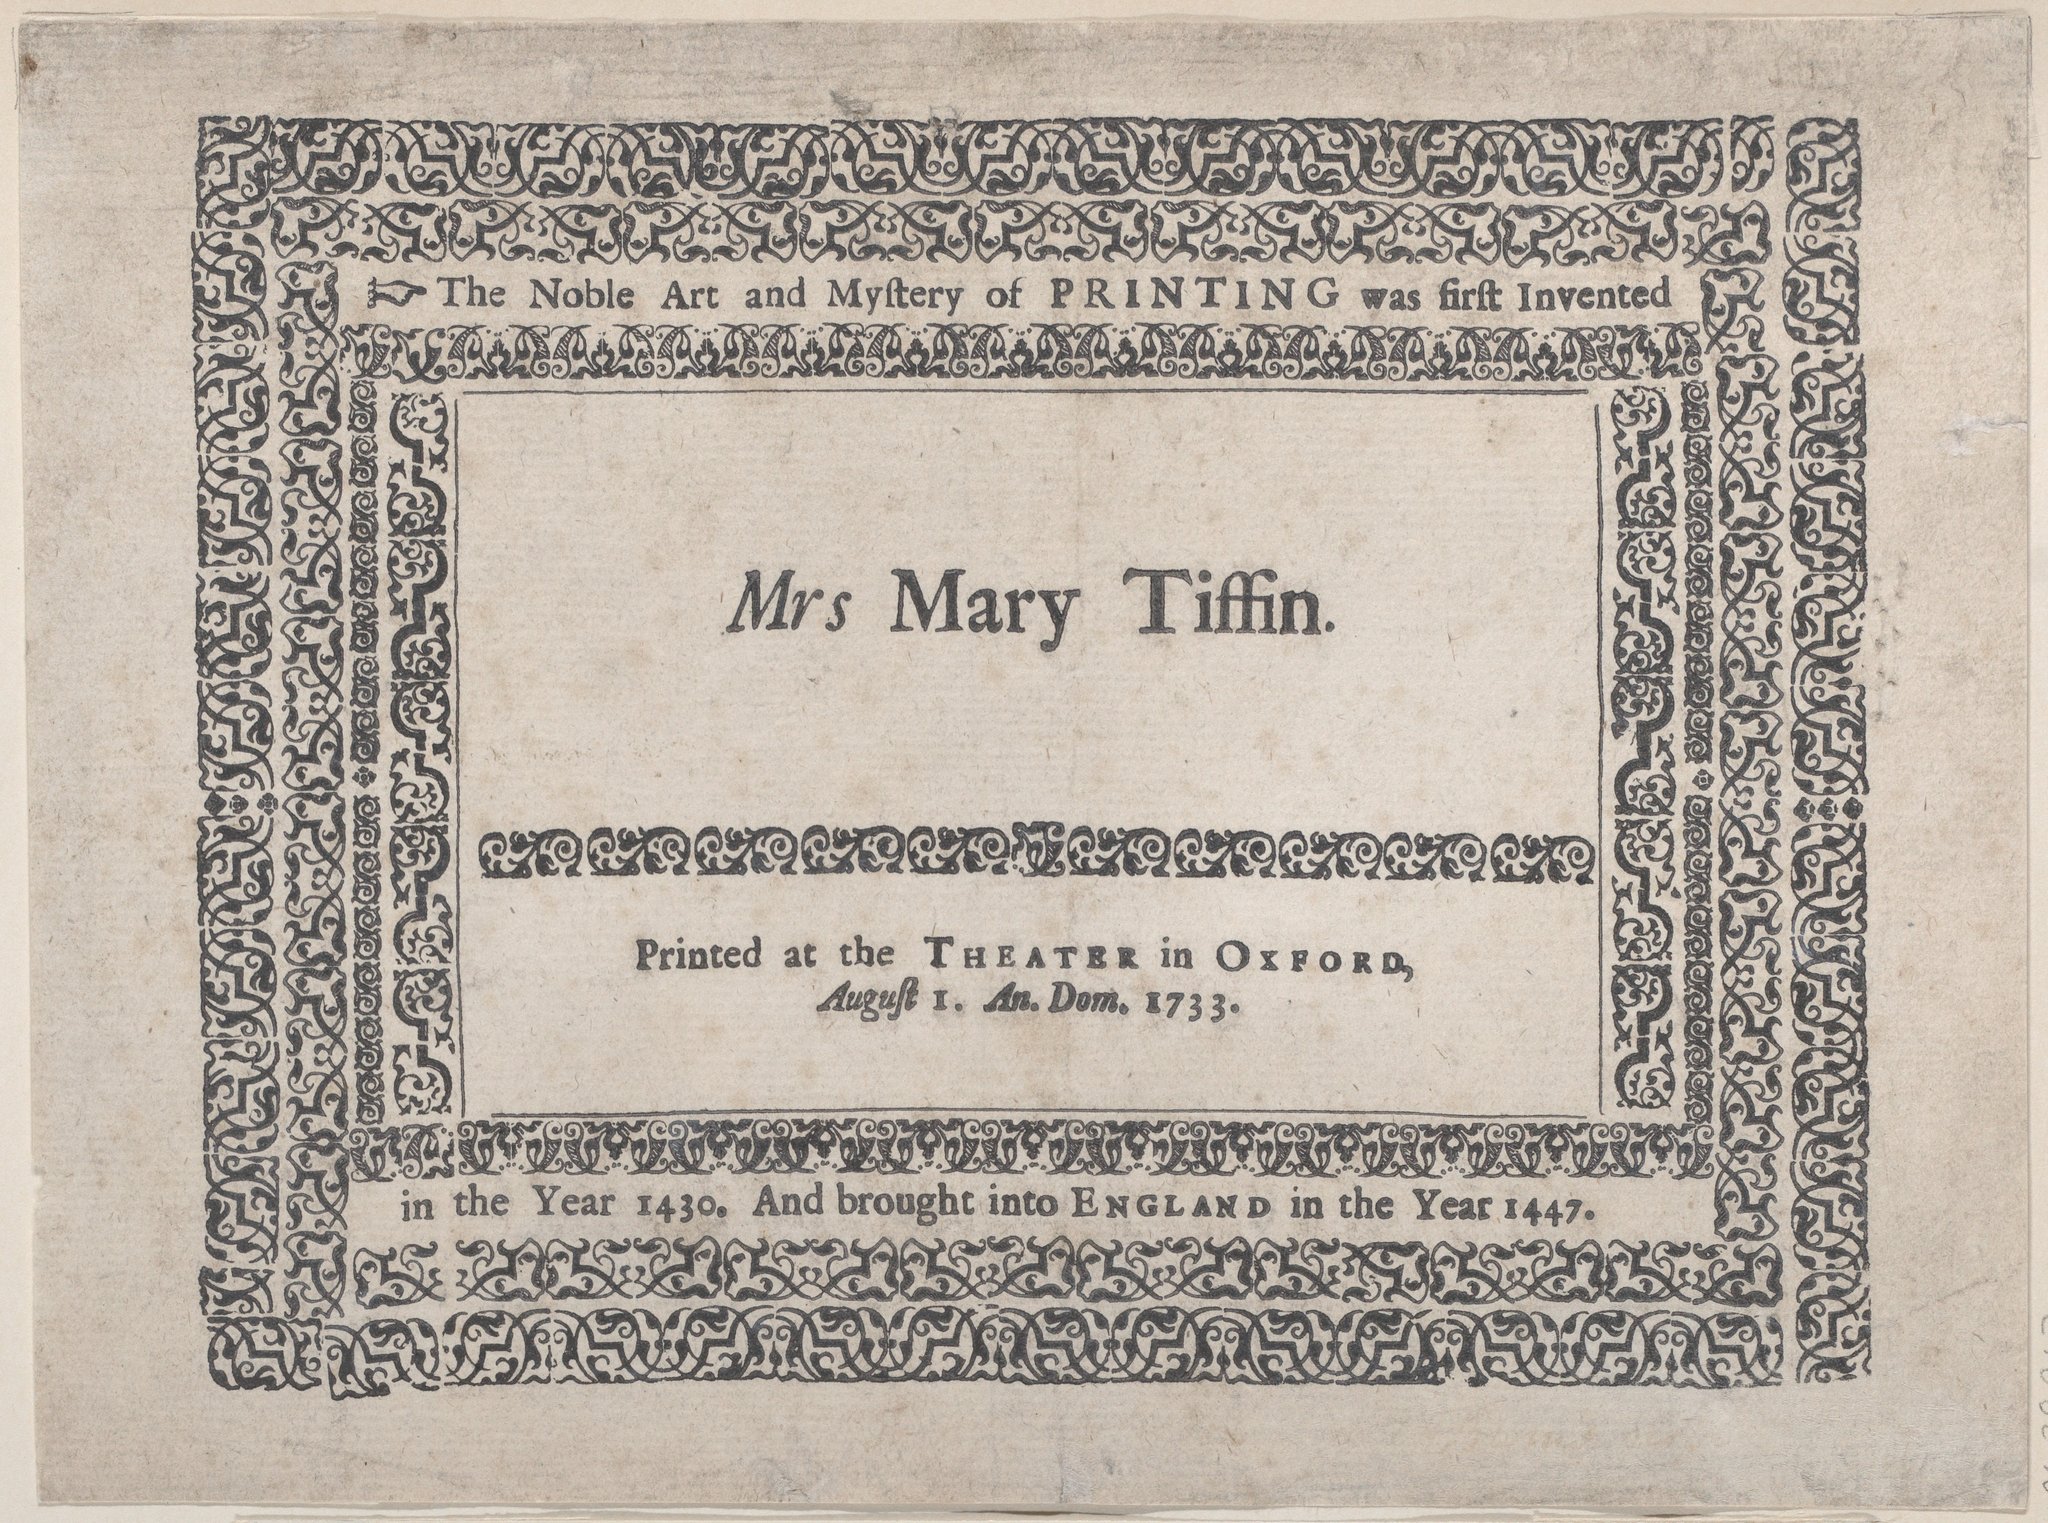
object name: print, trade card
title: Trade Card for the Theater in Oxford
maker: anonymous, british, 18th century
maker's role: artist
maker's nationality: british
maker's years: 1700-1800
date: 1701-1800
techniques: engraving